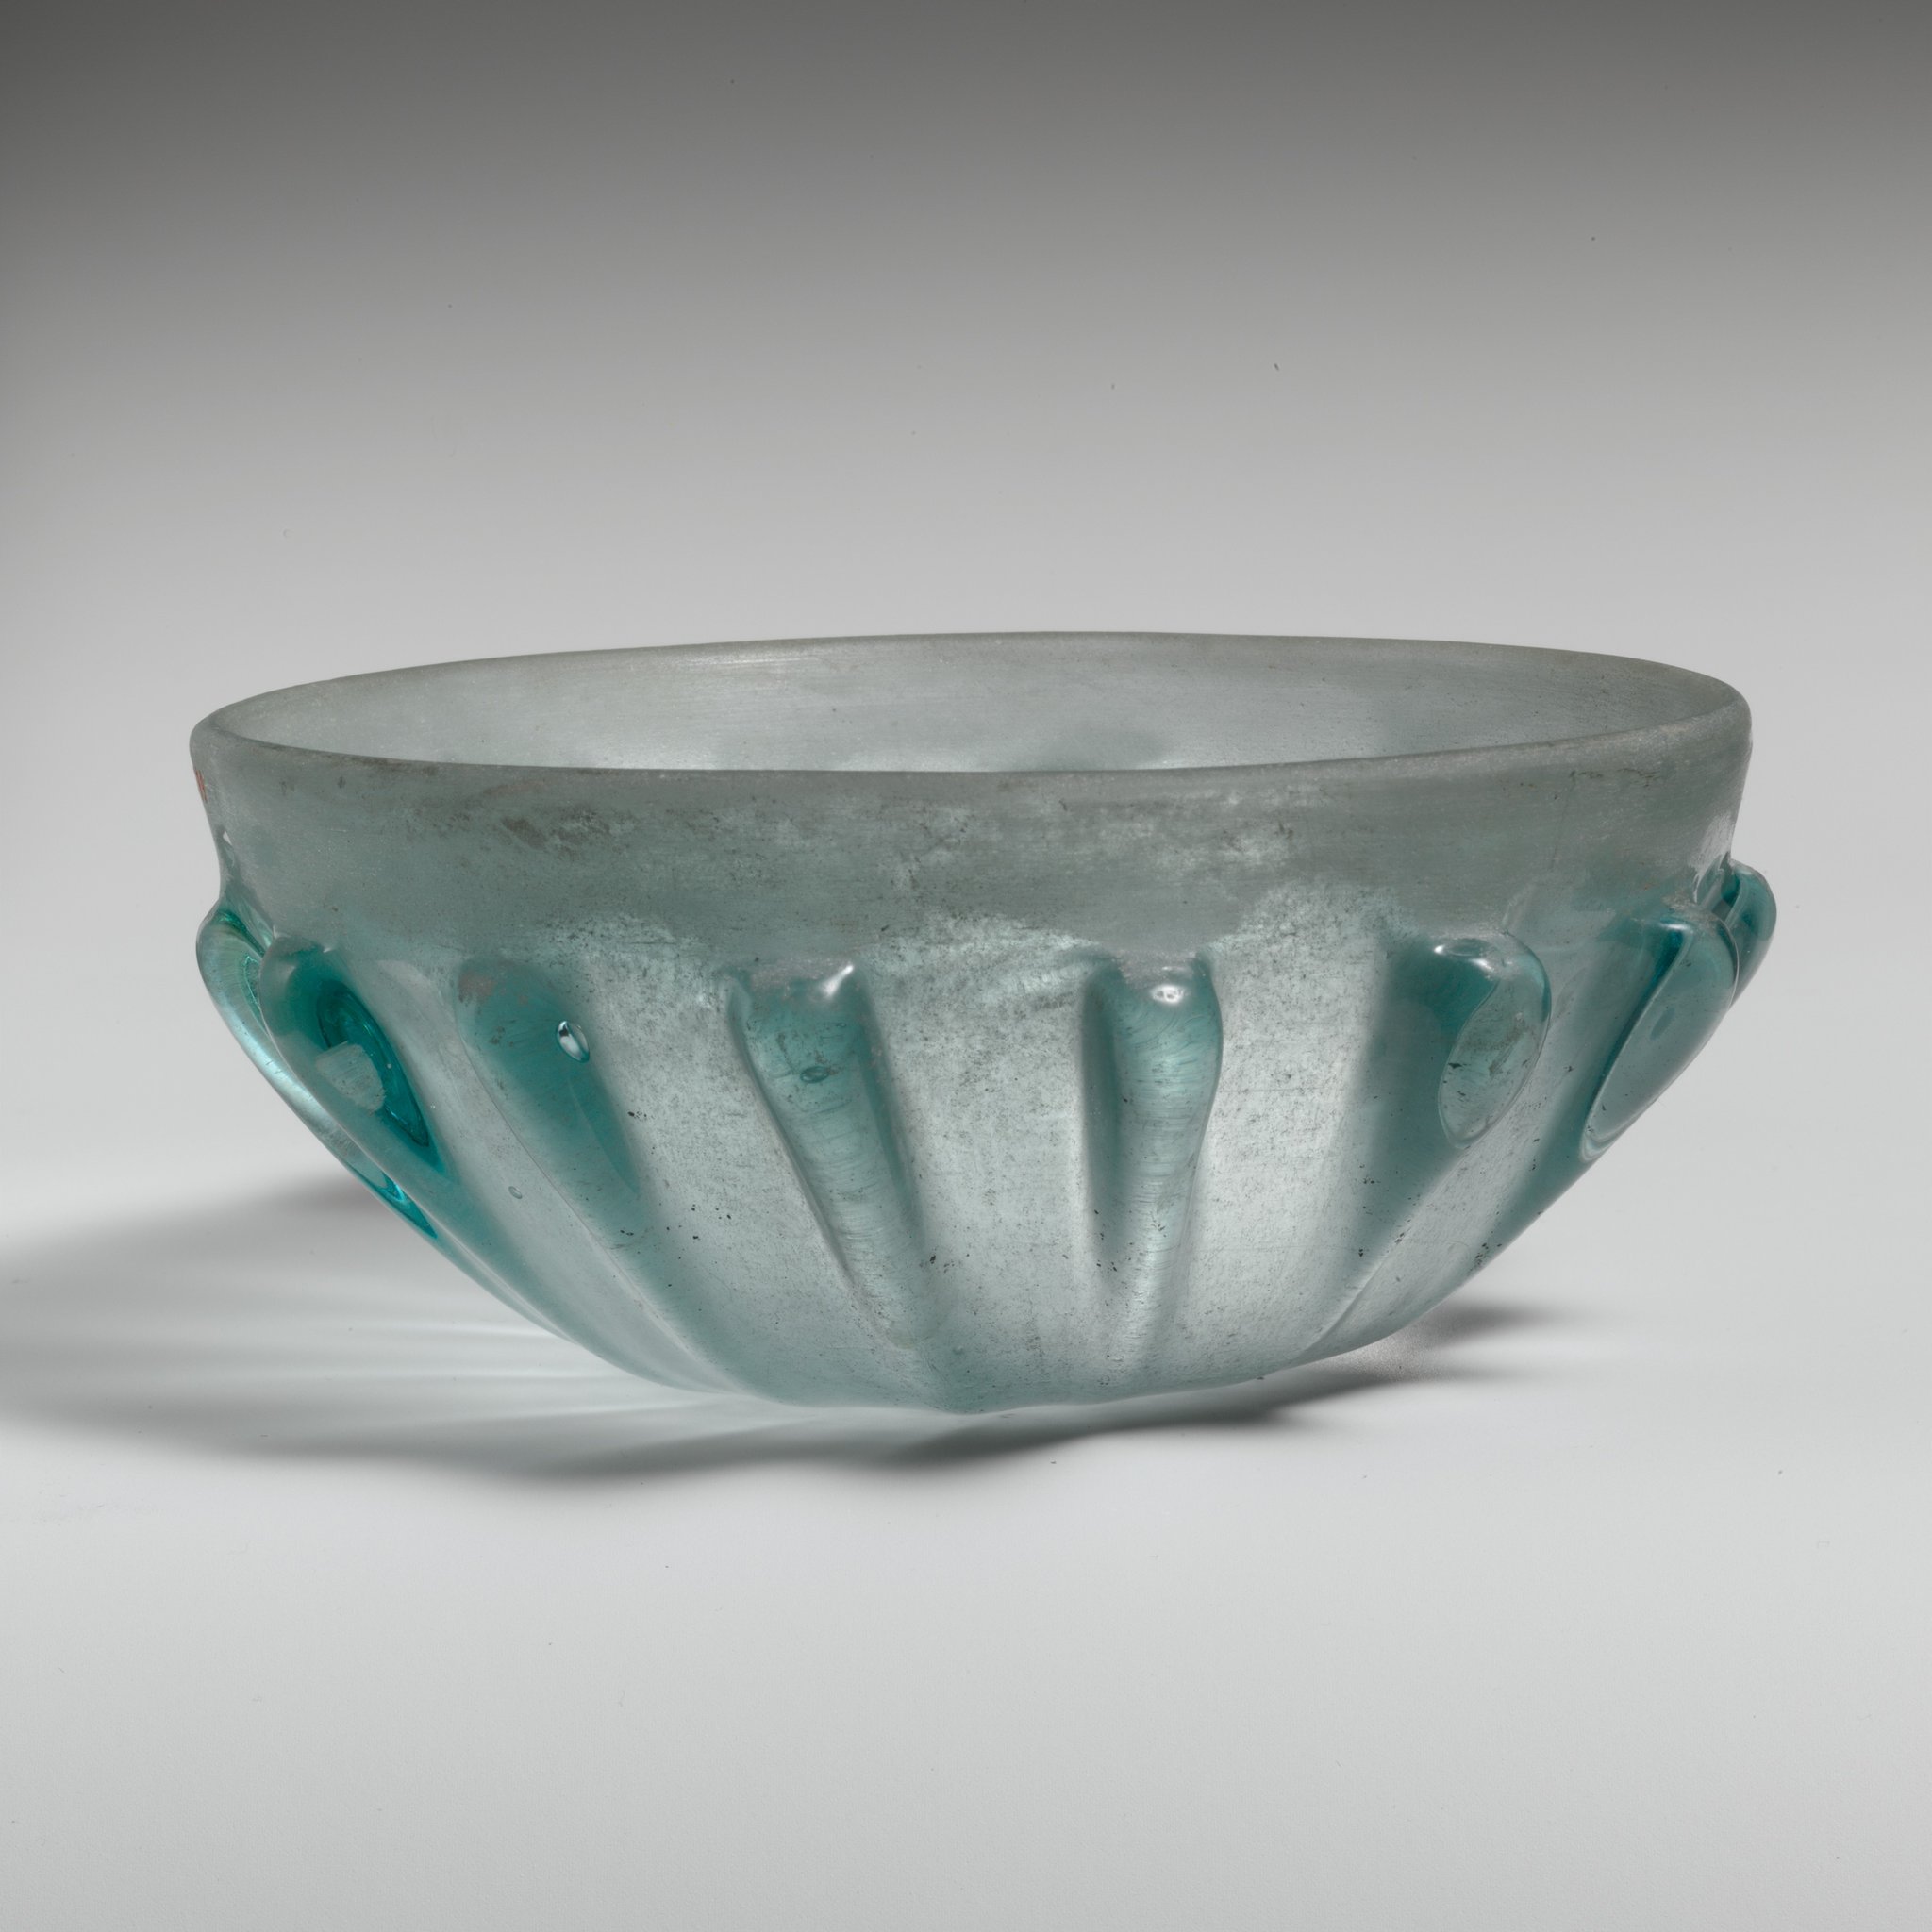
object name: bowl, ribbed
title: Glass ribbed bowl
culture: roman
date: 67-100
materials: glass